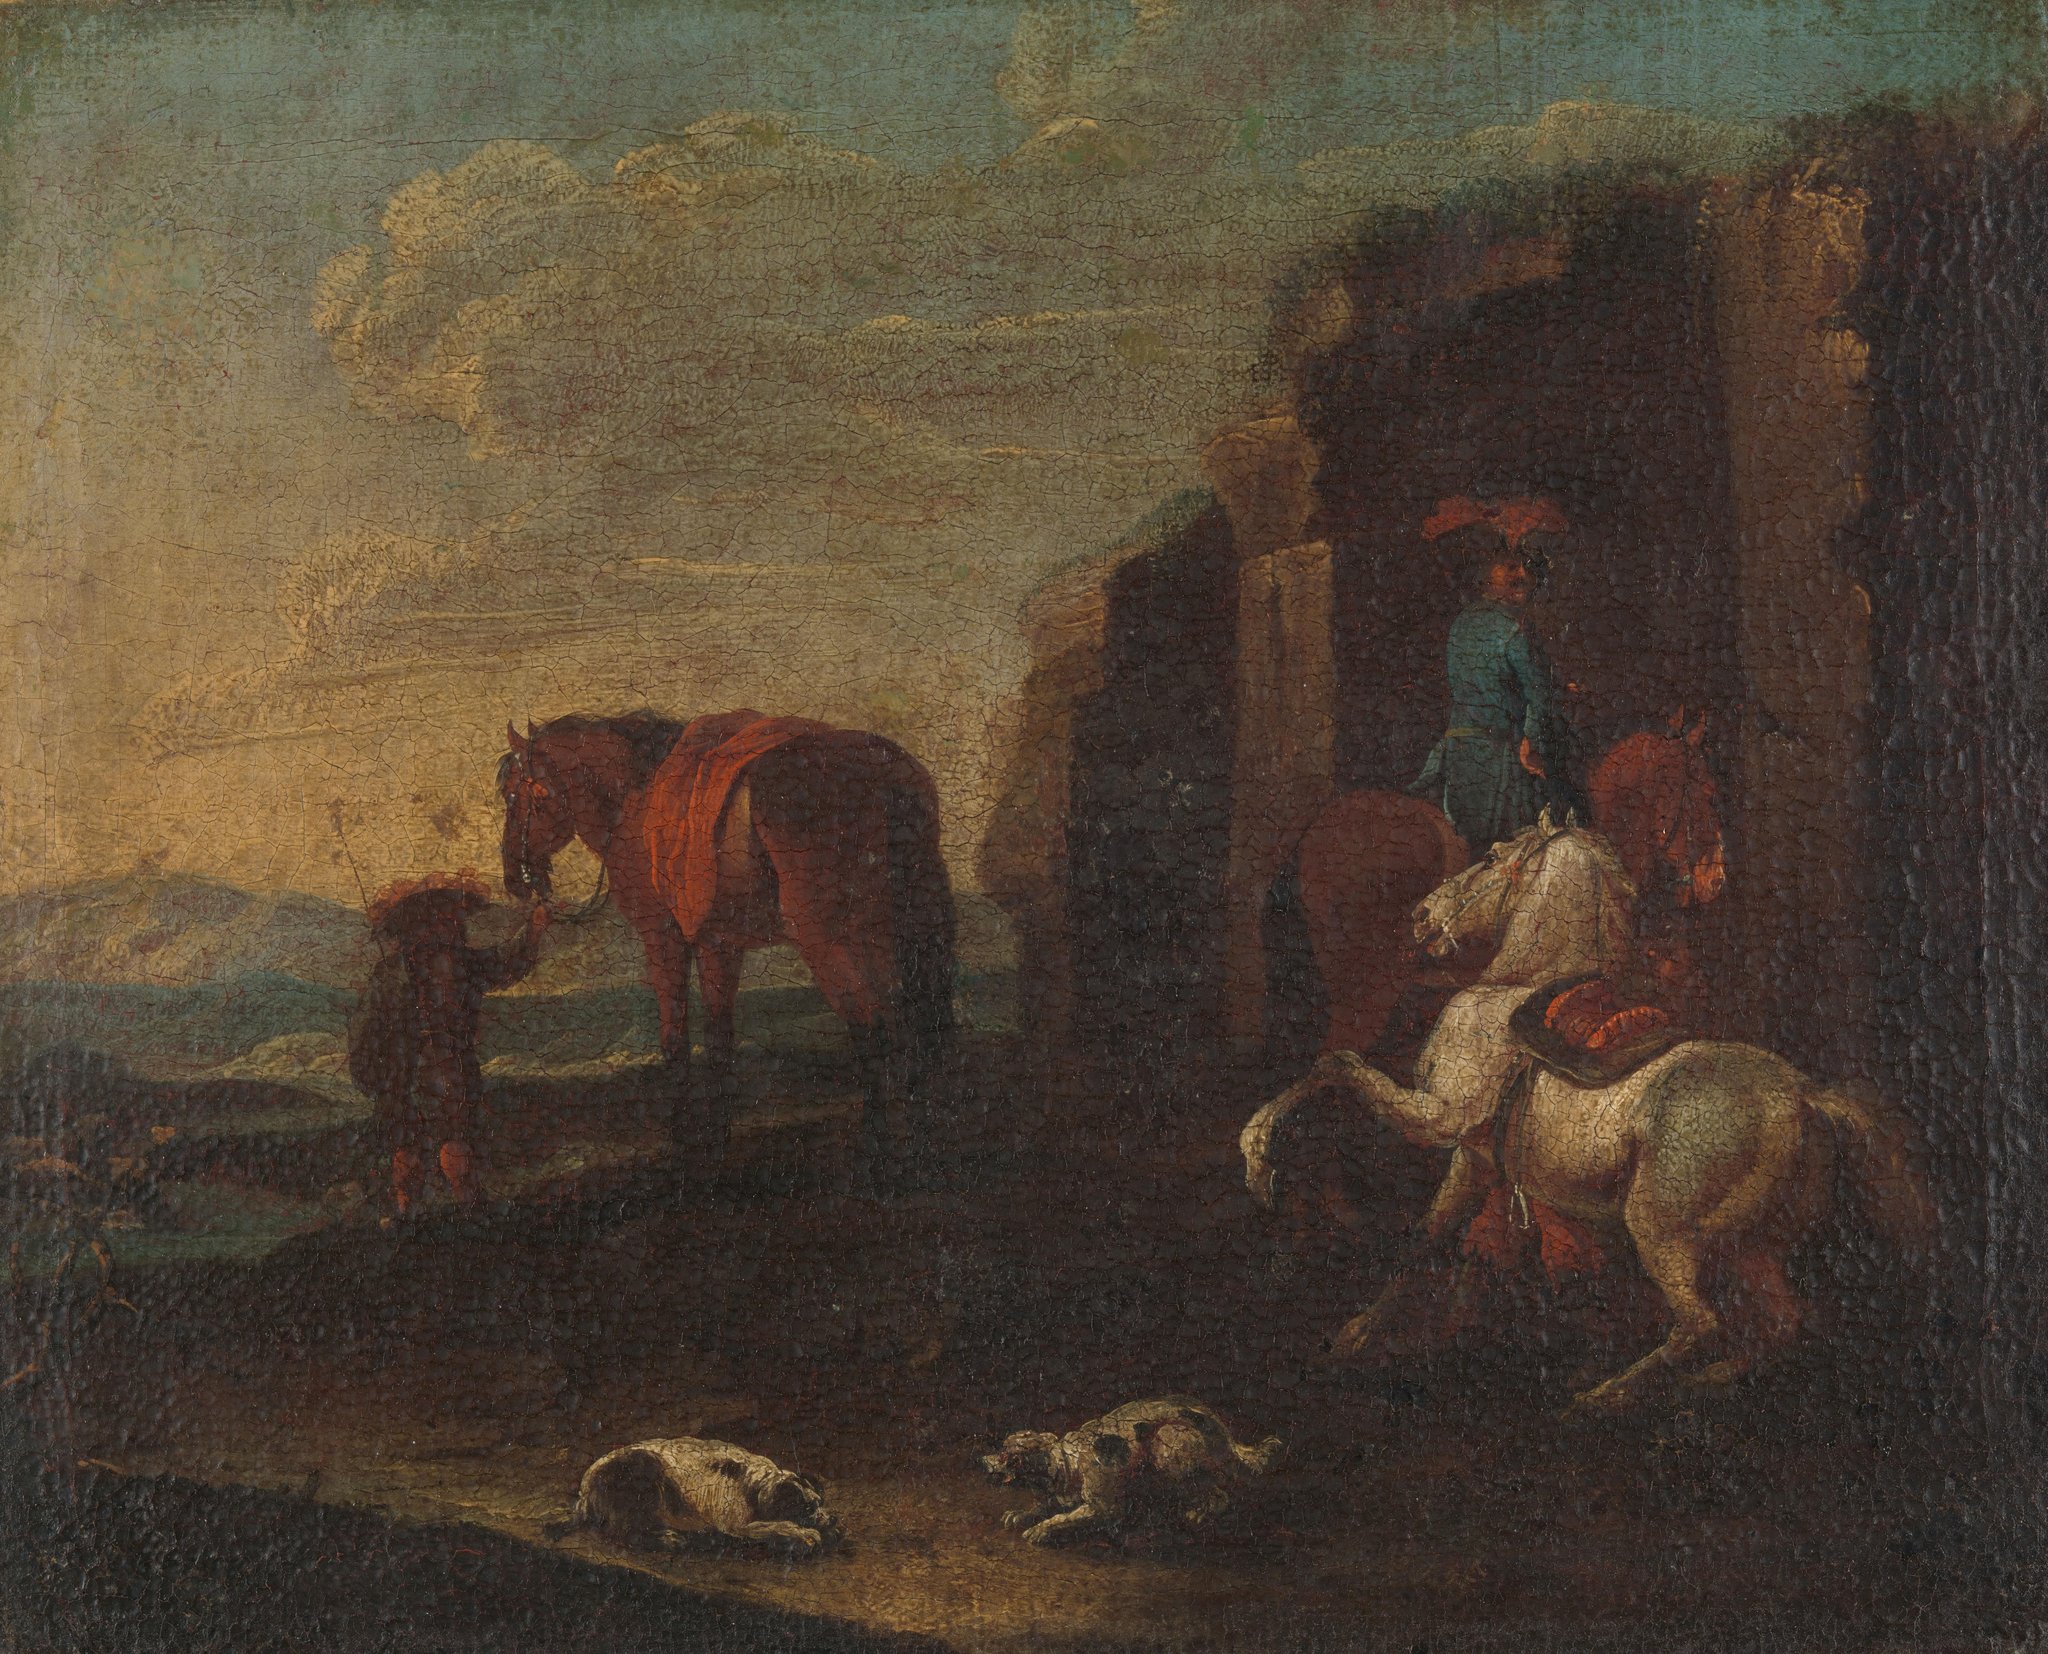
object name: painting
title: Travellers by a Ruin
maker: Anonymous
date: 1700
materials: canvas, oil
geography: low countries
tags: riding a horse, ass, or mule; rider, horseman, landscape with ruins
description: Italiaans landschap met ruiters met paarden bij een ruïne.